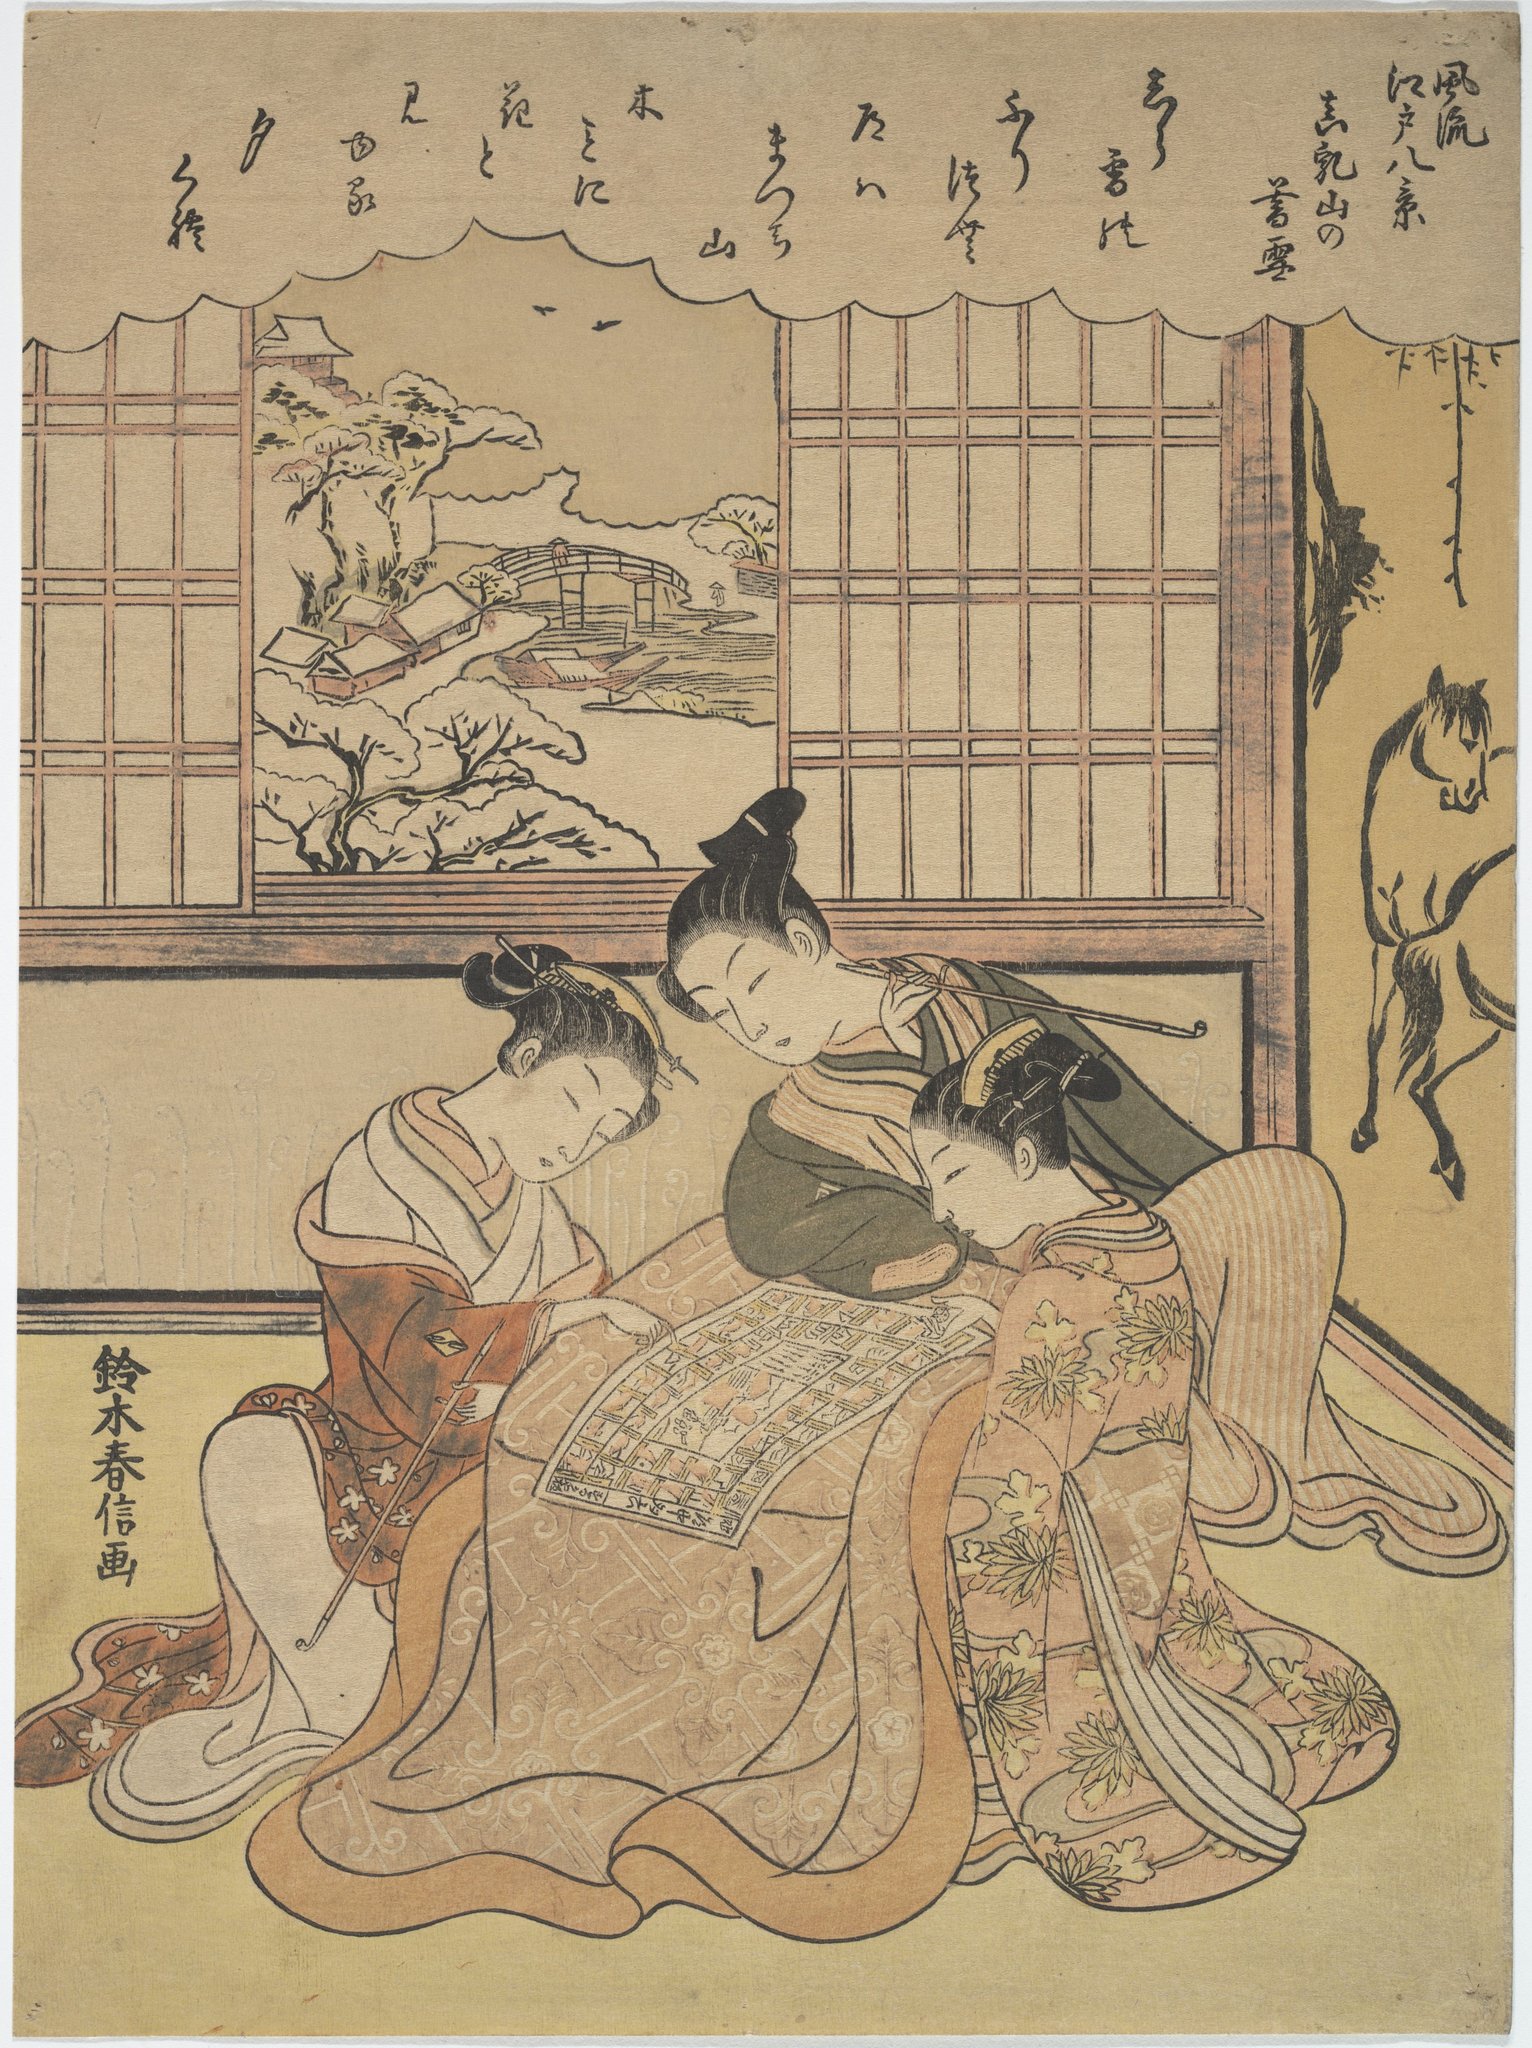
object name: print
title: Evening Snow on Matsuchi Hilll, from the series Eight Fashionable Views of Edo (Furyu Edo hakkei)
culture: japanese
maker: suzuki harunobu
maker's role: artist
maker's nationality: japanese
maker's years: 1725-1770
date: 1765-1770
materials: ink, paper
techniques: woodblock print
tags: women,games,pipes